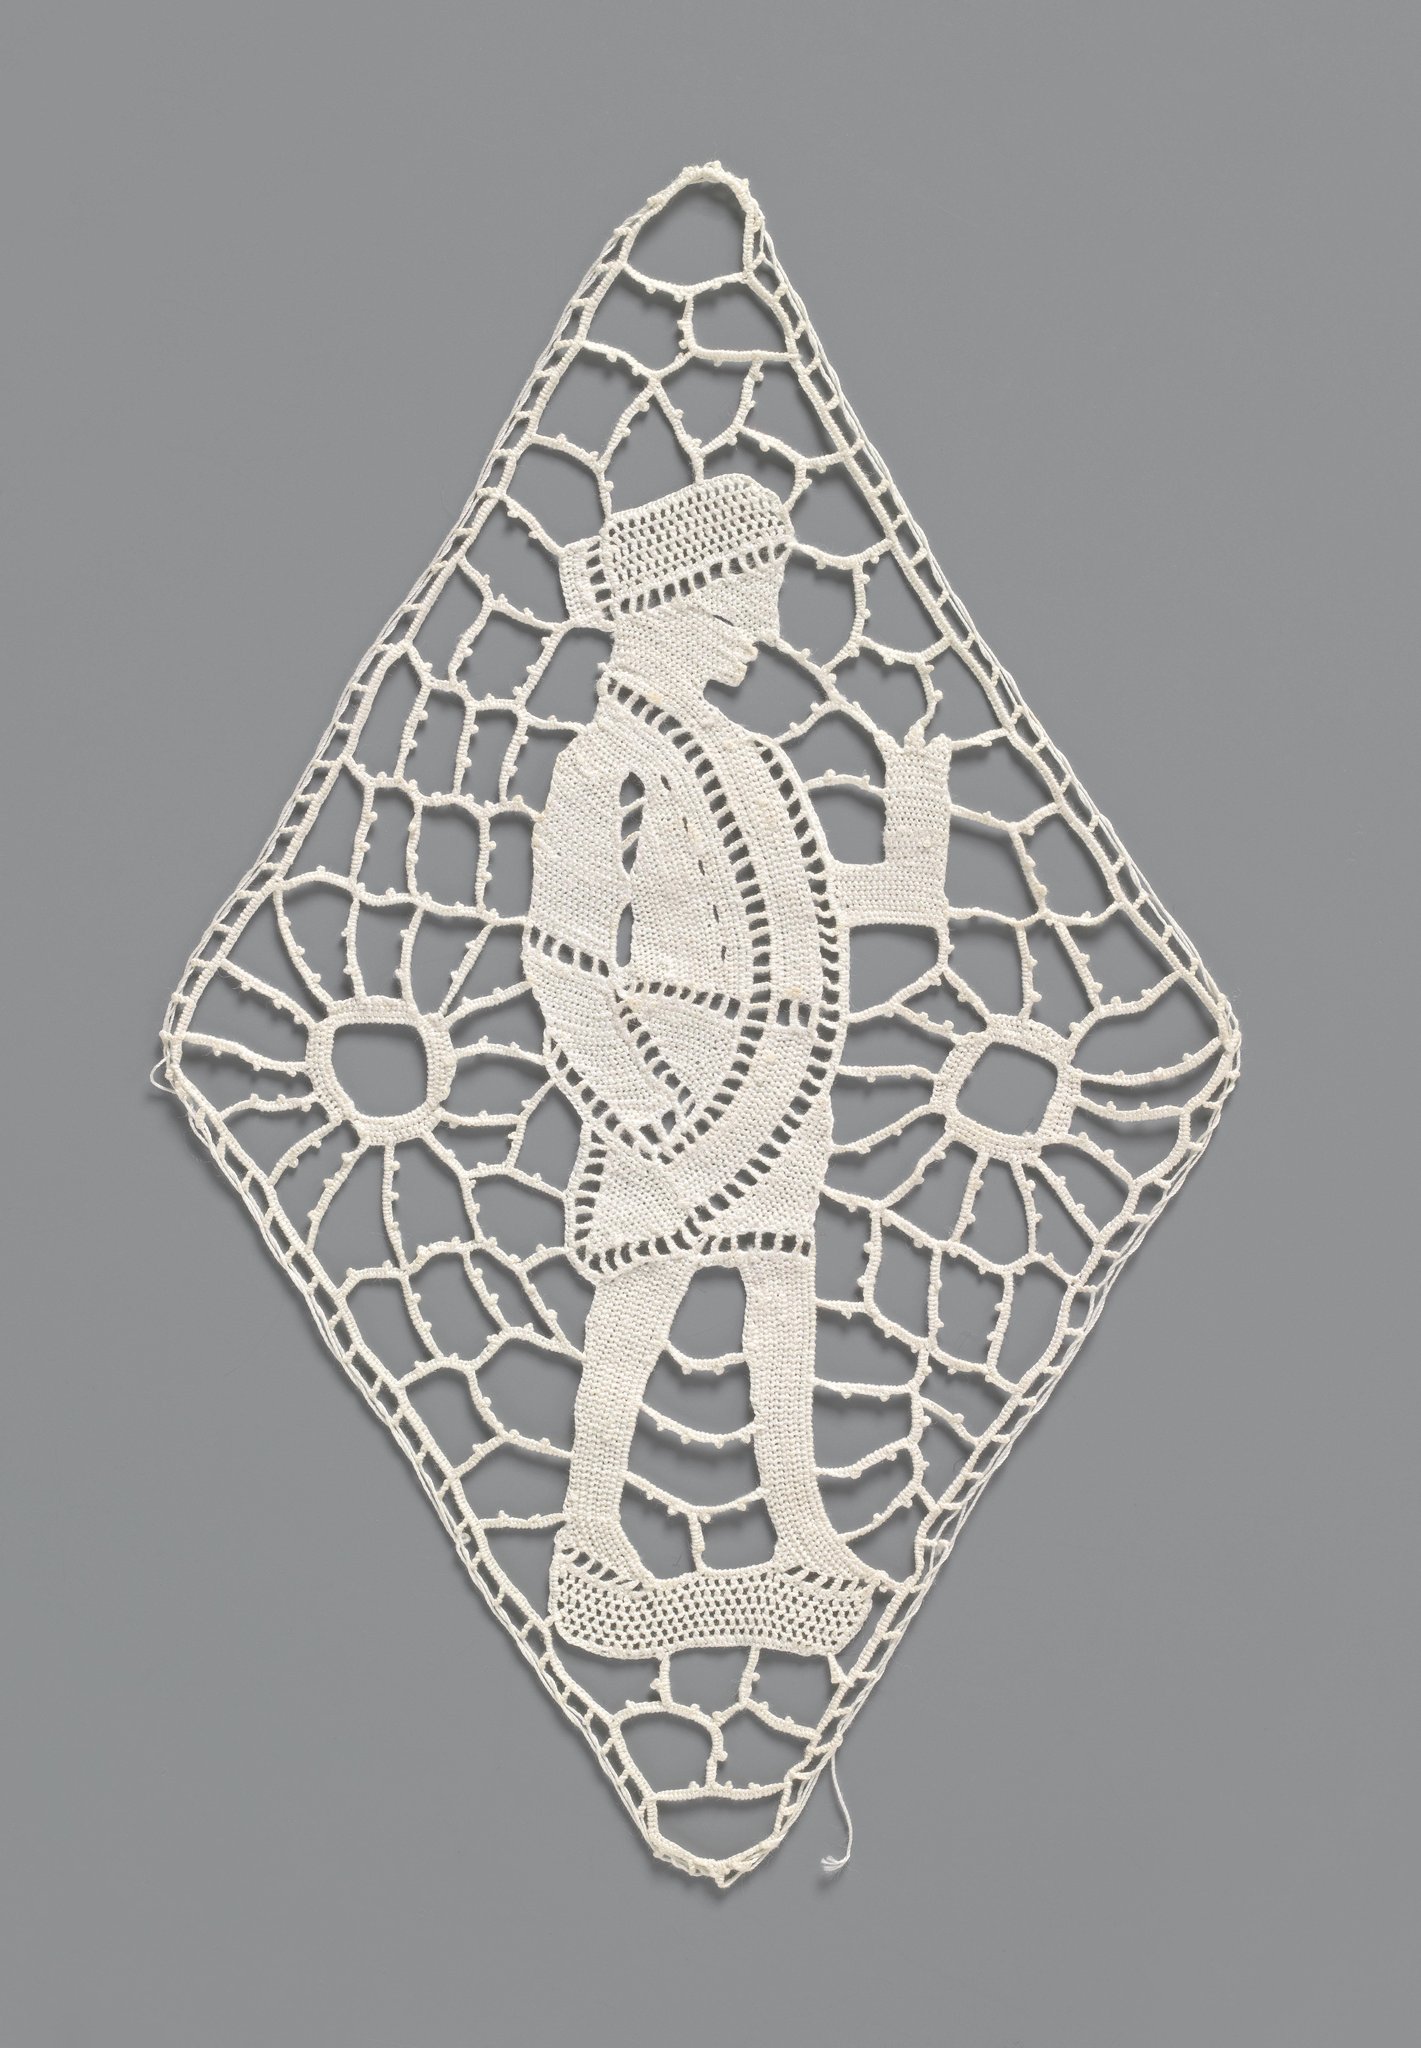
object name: inzetstuk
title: Inzetstuk van naaldkant in de vorm van een ruit met een mens die een jas aan heeft en een hand opsteekt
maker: Anonymous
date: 1920-1935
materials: cotton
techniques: flat venetian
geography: czechoslovakia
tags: human being, man in general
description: Inzetstuk van naaldkant: platte Venetiaanse kant. Ruitvormig model. Het patroon bestaat uit een mens met een rondgesneden jas aan en een rond 'pillbox' hoedje. Hij of zij steekt één hand op terwijl de andere hand in de jas(zak) steekt. Aan weerszijden, in de hoeken van het ruit, wordt de mens geflankeerd door vierkante bloem of zon. De motieven zijn gemaakt in dichtgewerkte festonsteken met uitsparingen. De motieven zijn met elkaar verbonden door gepicoteerde spijlen.